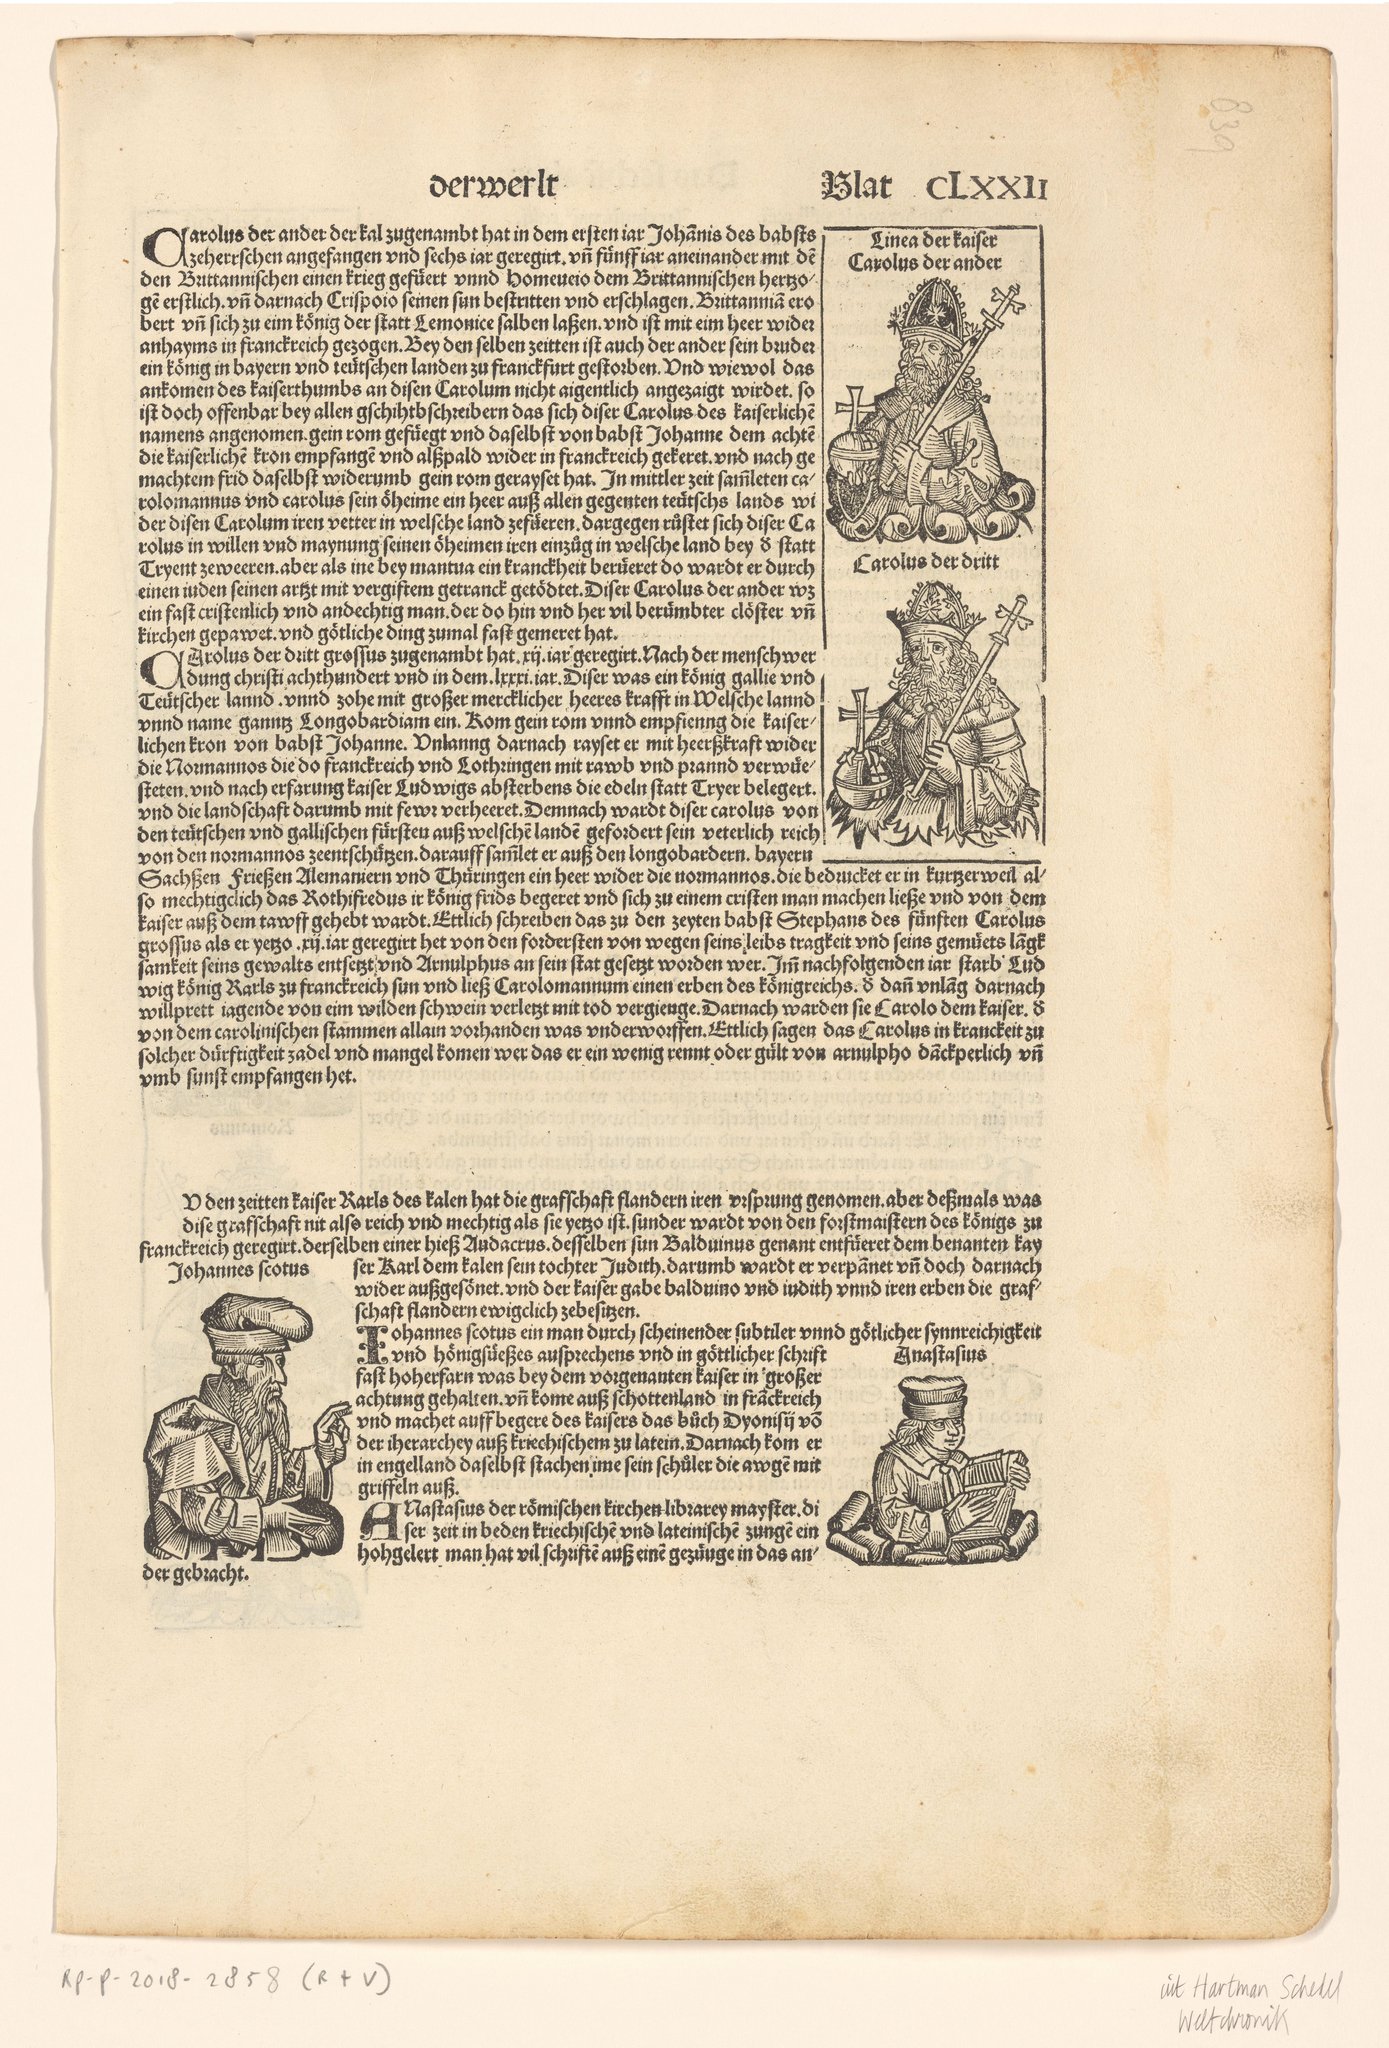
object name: print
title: Bladzijde uit de Neurenbergkroniek van Schedel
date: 1493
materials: paper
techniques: woodcut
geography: nuremberg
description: Afkomstig uit: Schedel, Hartmann. Die Schedelsche Weltchronik. Neurenberg: Anton Koberger, 1493.